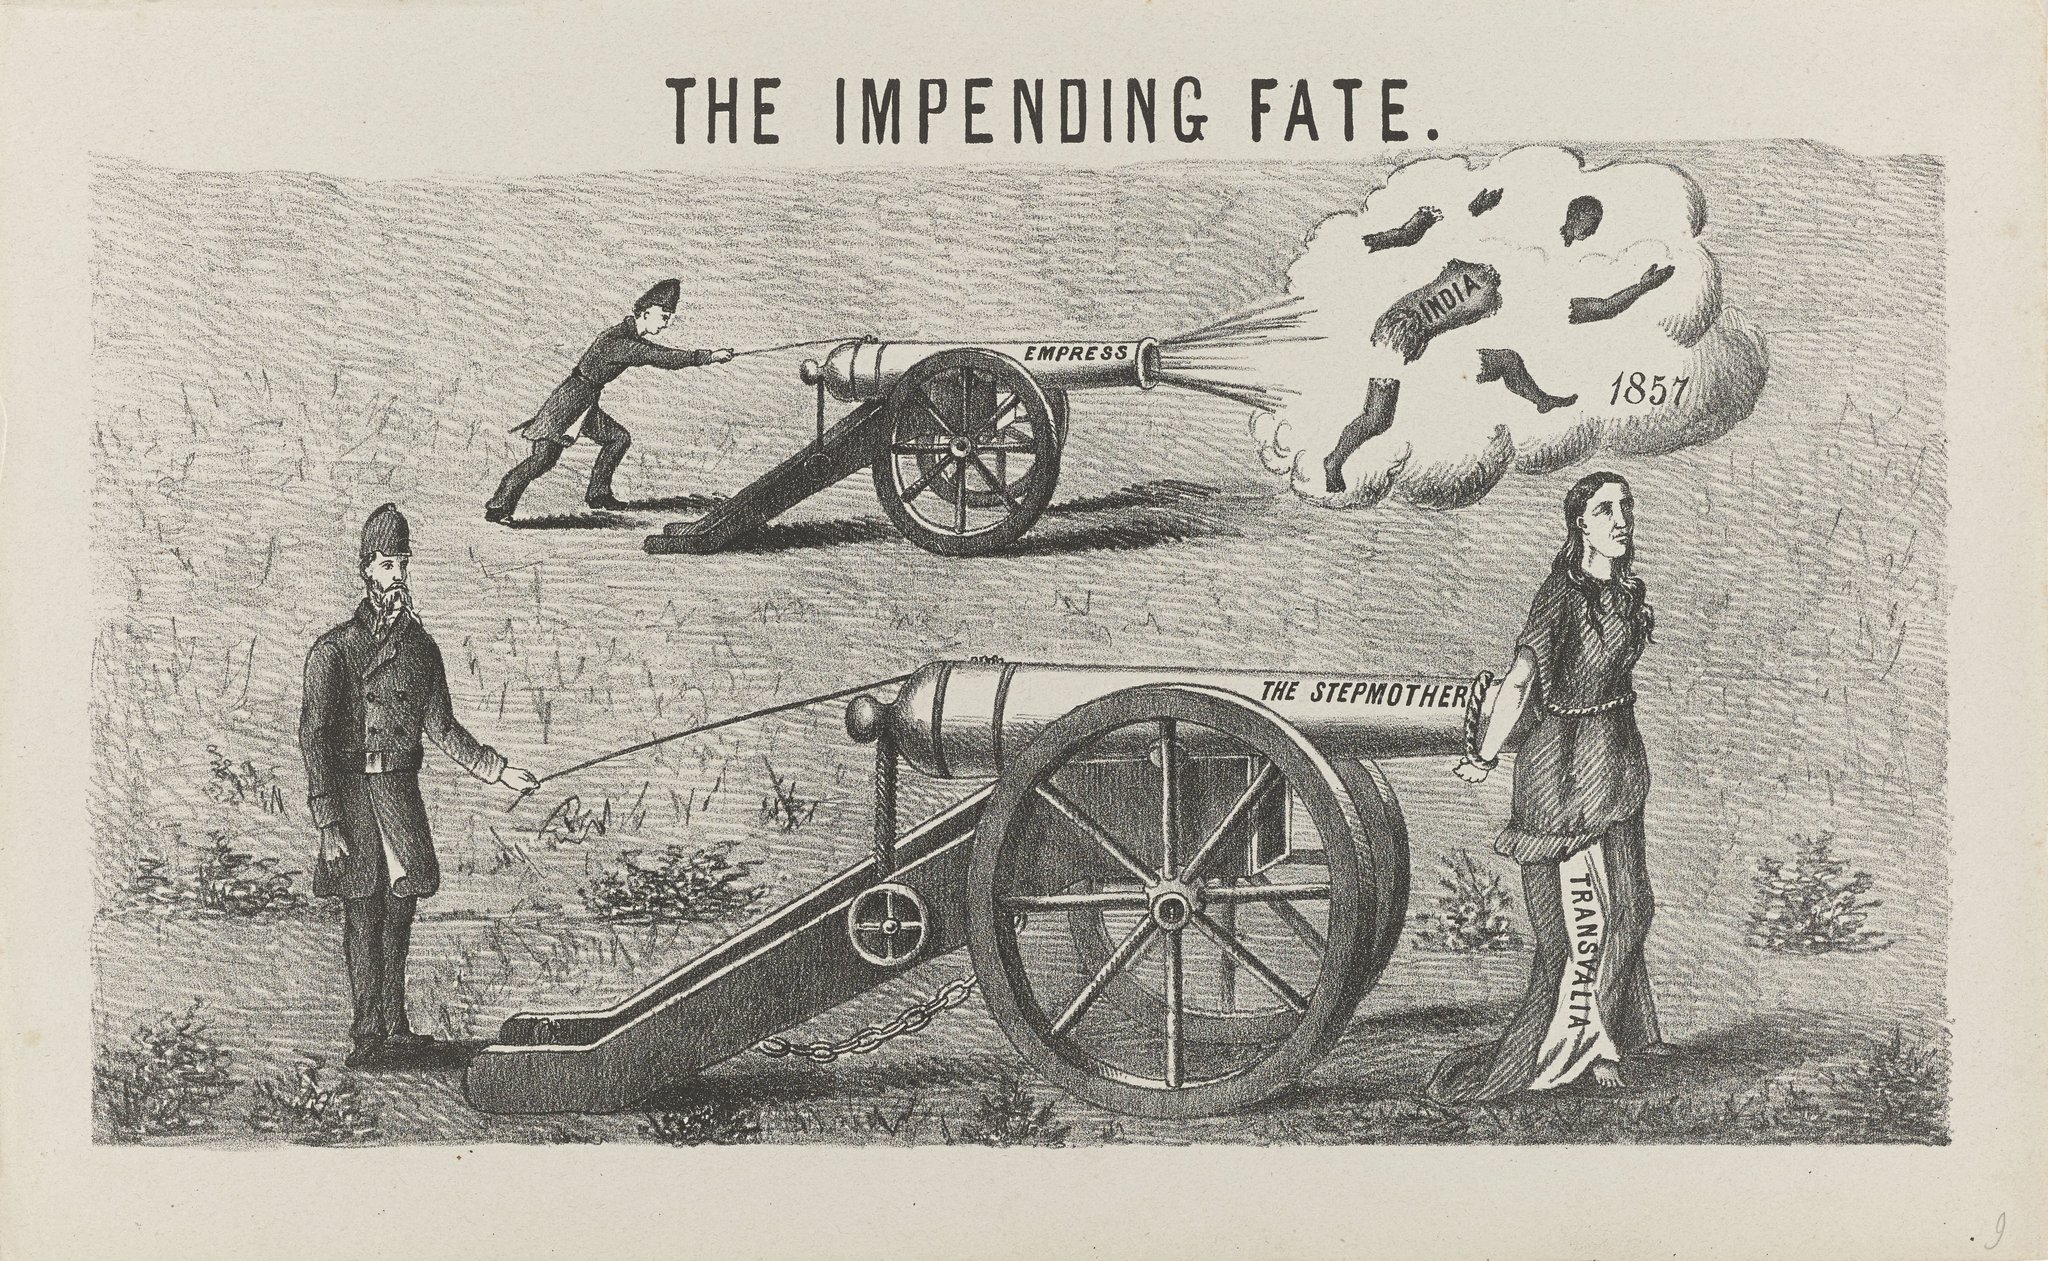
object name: cartoon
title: The Impending Fate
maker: Anonymous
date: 1877-1880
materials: paper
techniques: lithograph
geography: south africa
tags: death penalty, execution, violent death by firearms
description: De personificatie van Transvaal staat vastgebonden voor de loop van een Brits kanon op het punt om terechtgesteld te worden. Op de achtergrond de executie op dezelfde wijze van India in 1857. Onderdeel van de serie van elf spotprenten op de Britse annexatie van Transvaal in 1877.